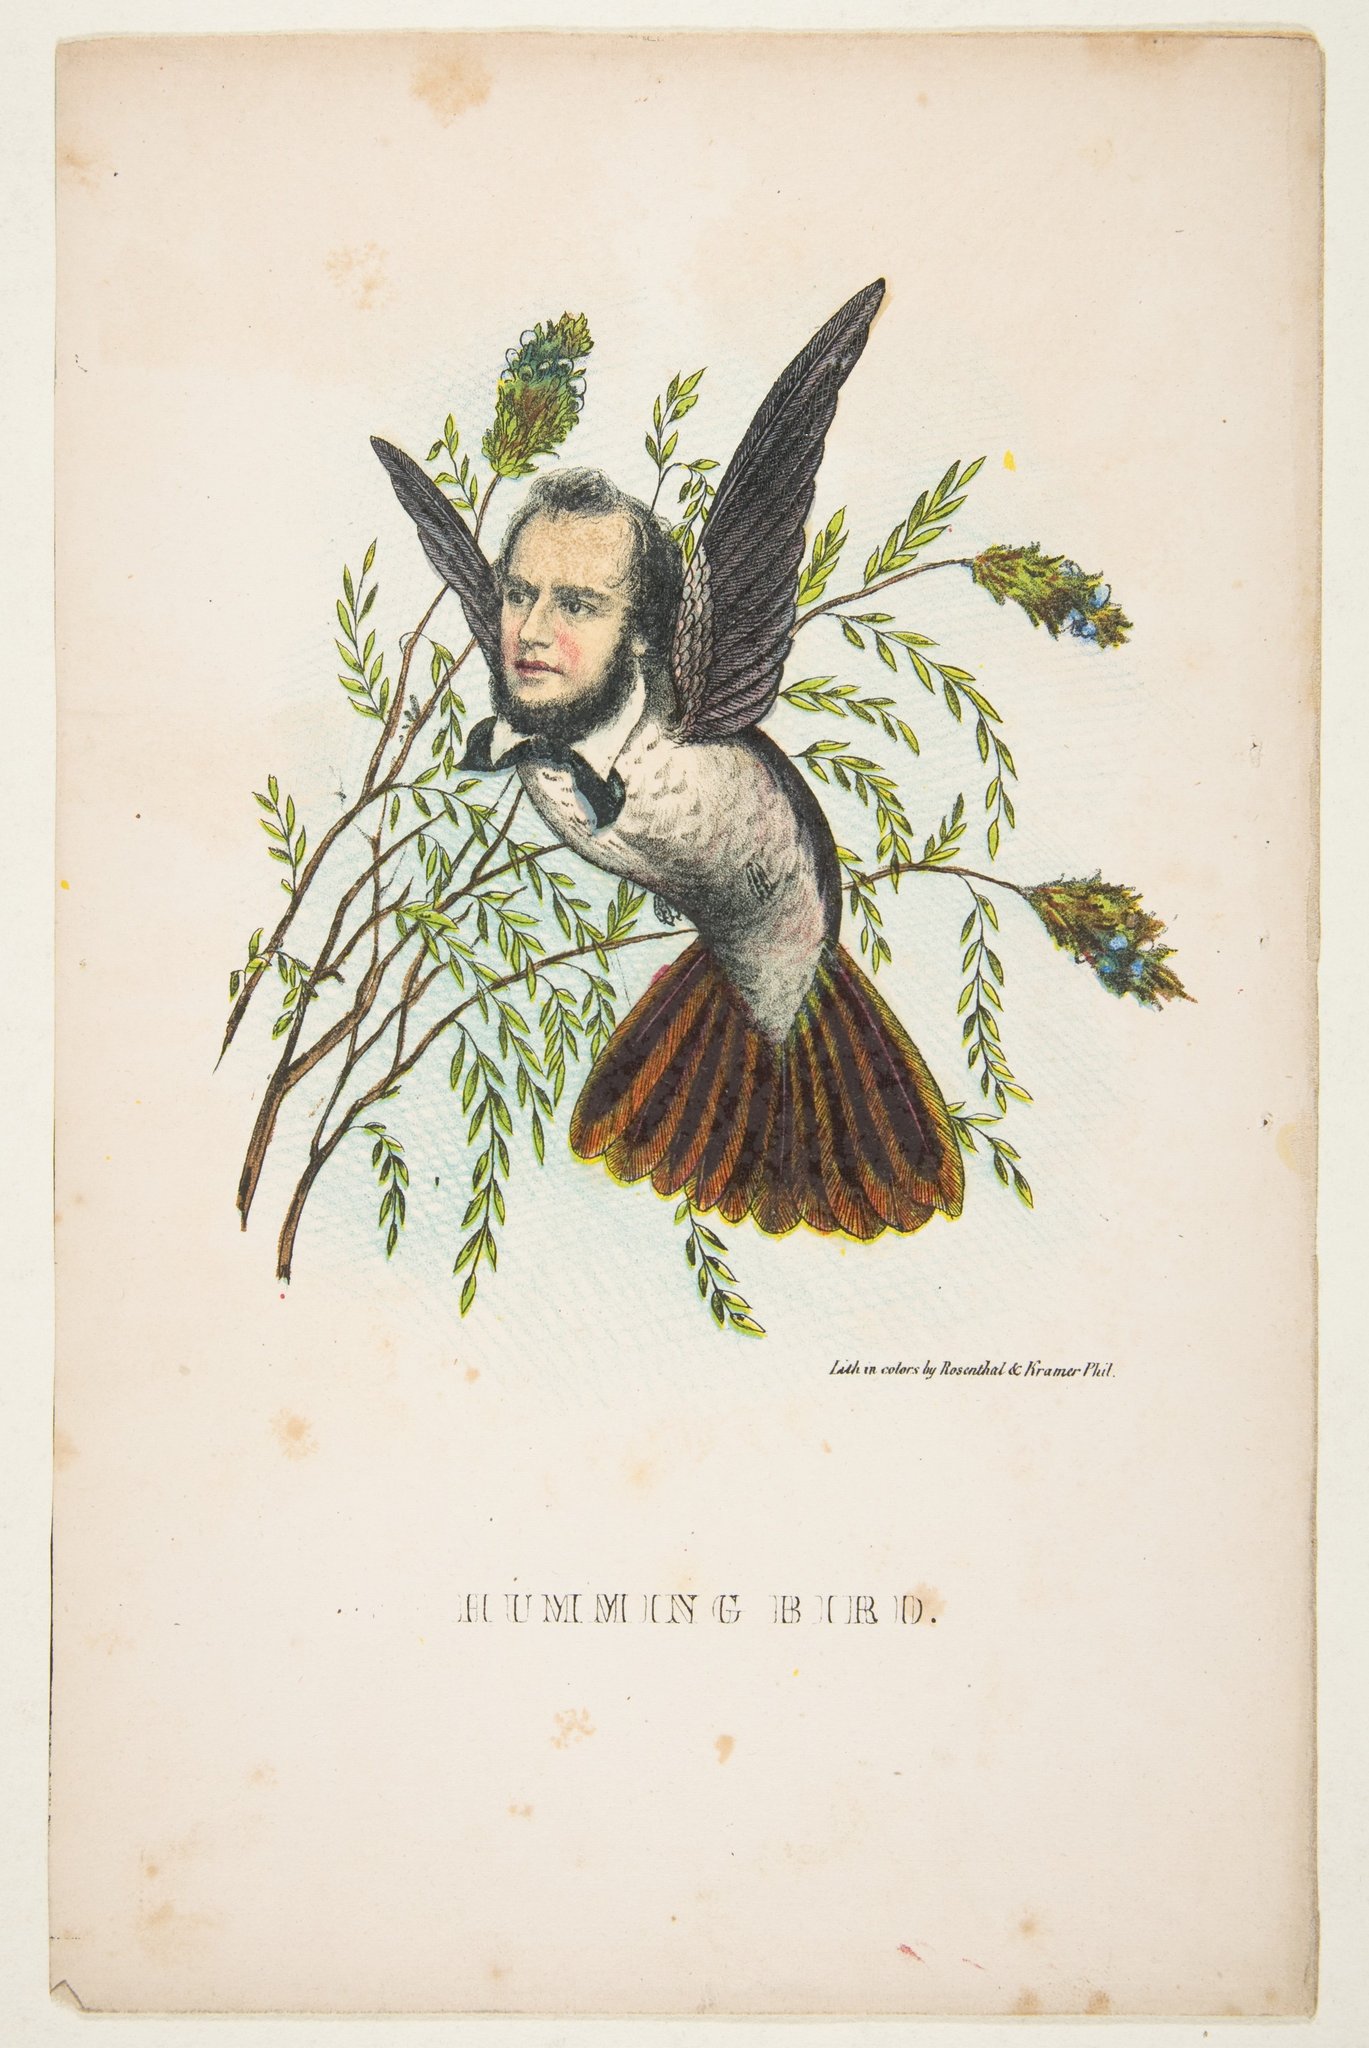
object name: print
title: Humming Bird (Thomas B. Florence), from "The Comic Natural History of the Human Race"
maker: henry louis stephens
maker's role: artist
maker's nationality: american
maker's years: 1824-1882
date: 1851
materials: watercolor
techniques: lithograph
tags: birds,faces,leaves